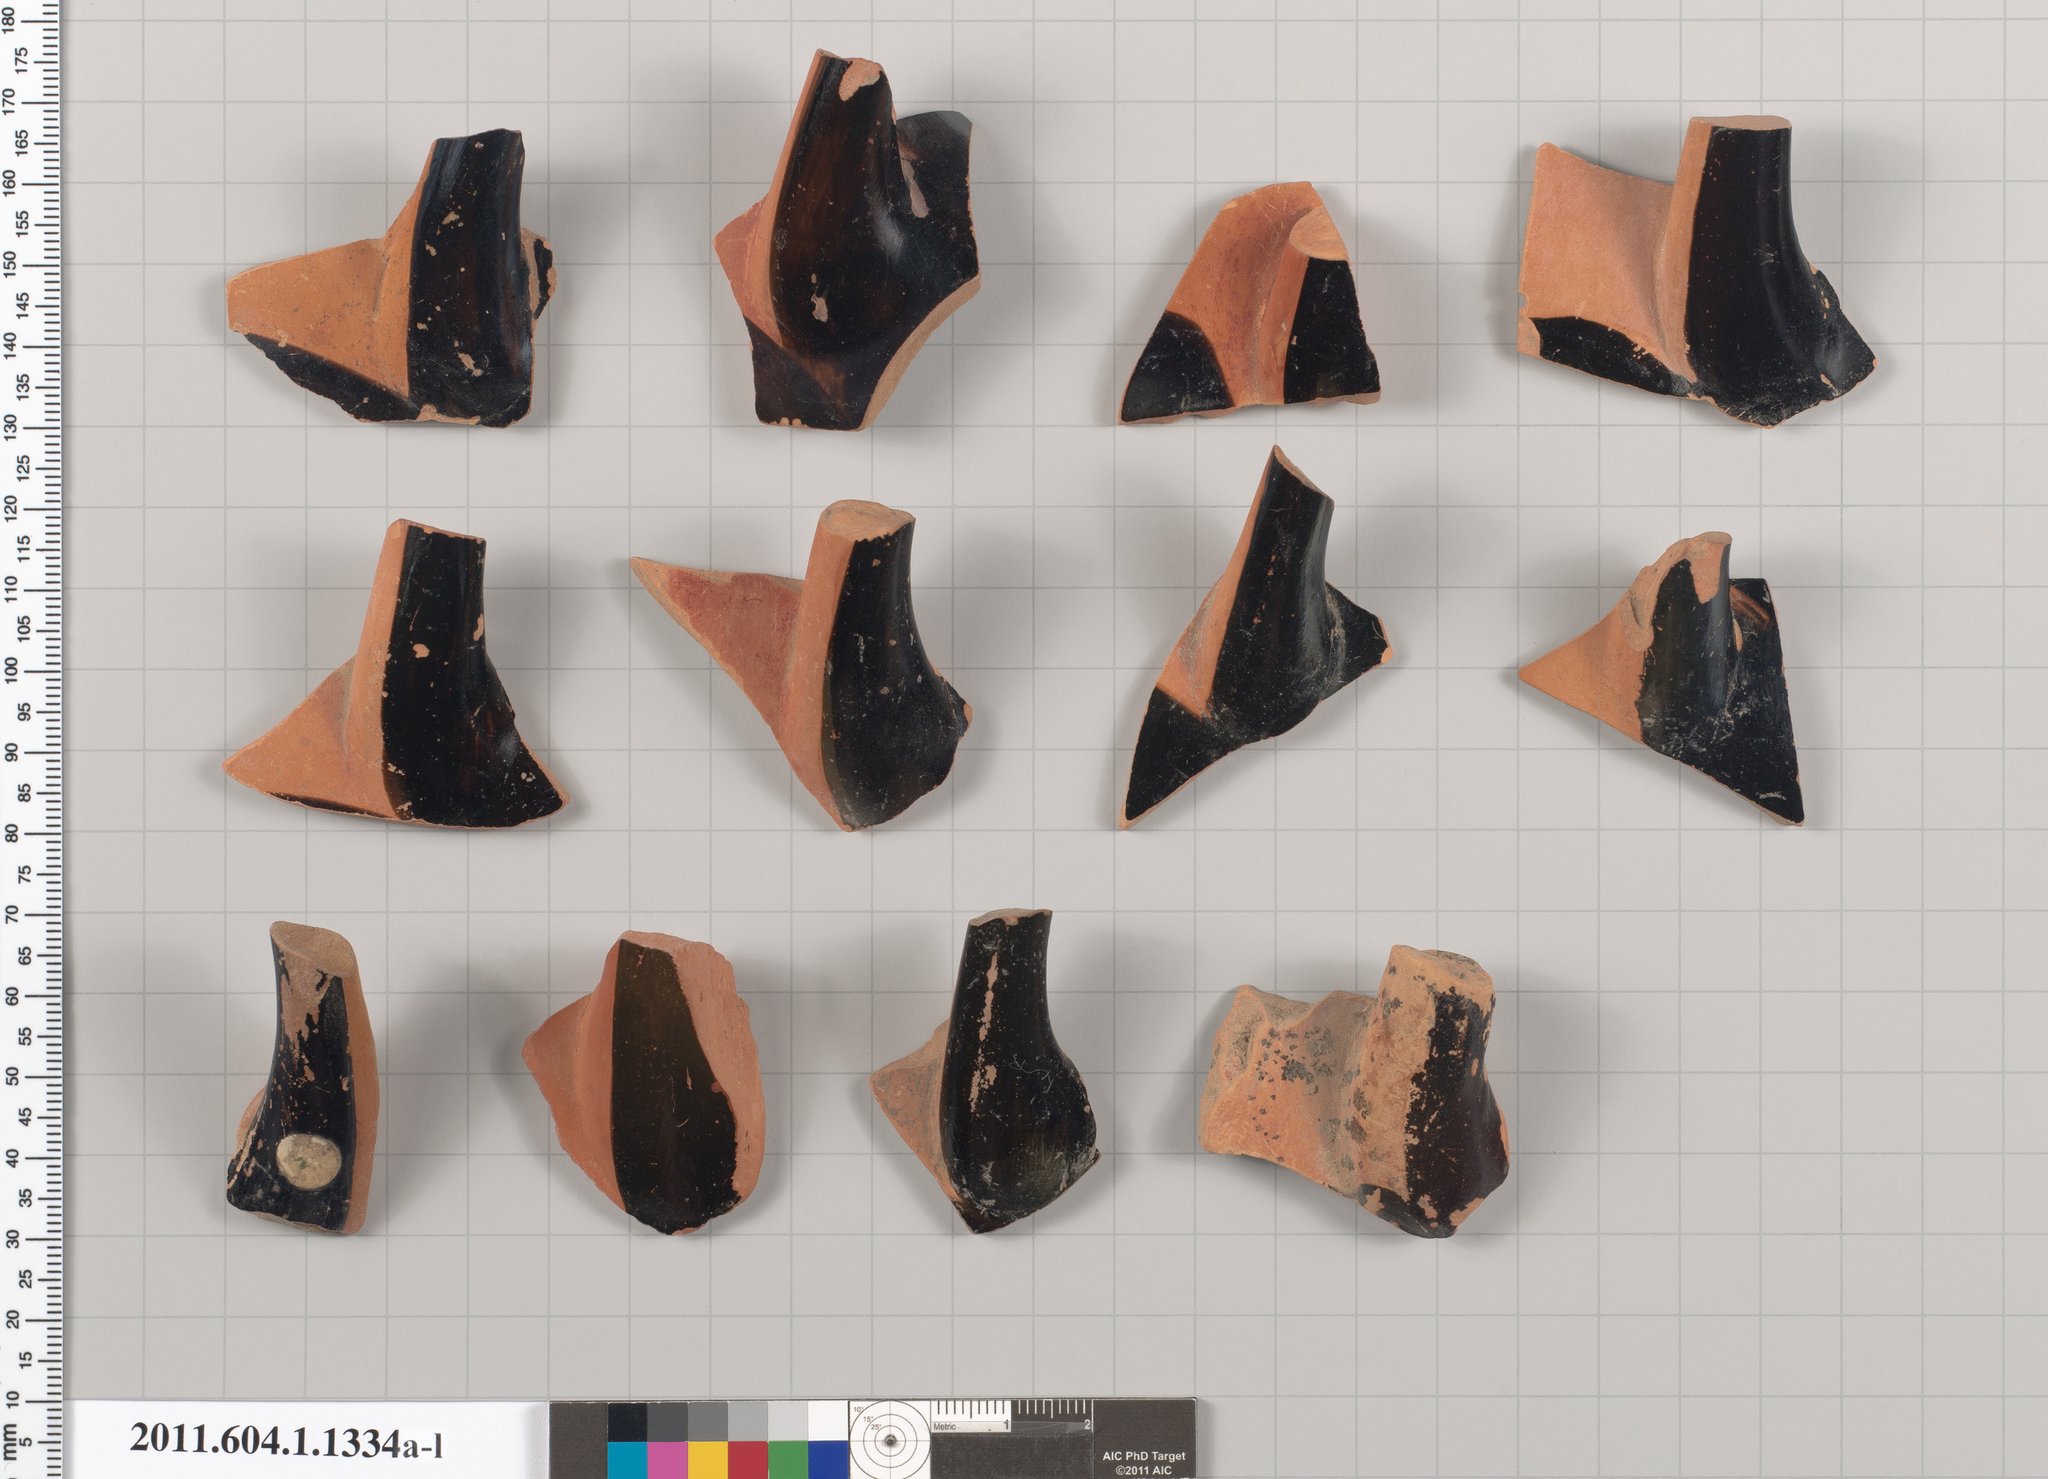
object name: kylix fragment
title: Terracotta fragments of kylikes (drinking cups)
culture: greek, attic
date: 500-401 BCE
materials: terracotta